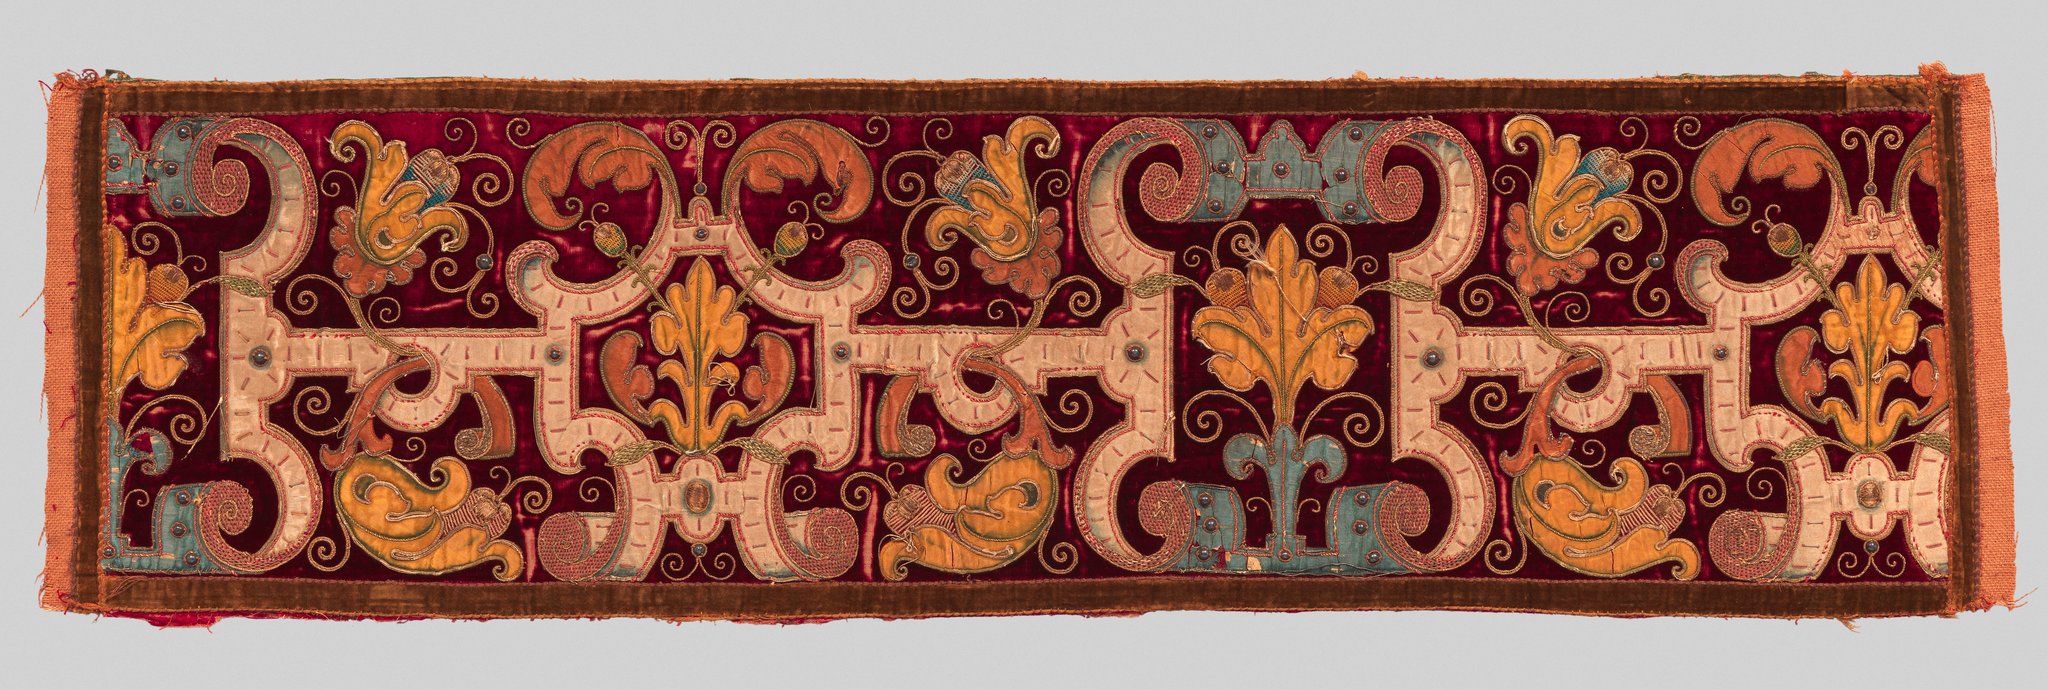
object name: band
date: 1601-1700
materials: metal thread, silk, velvet